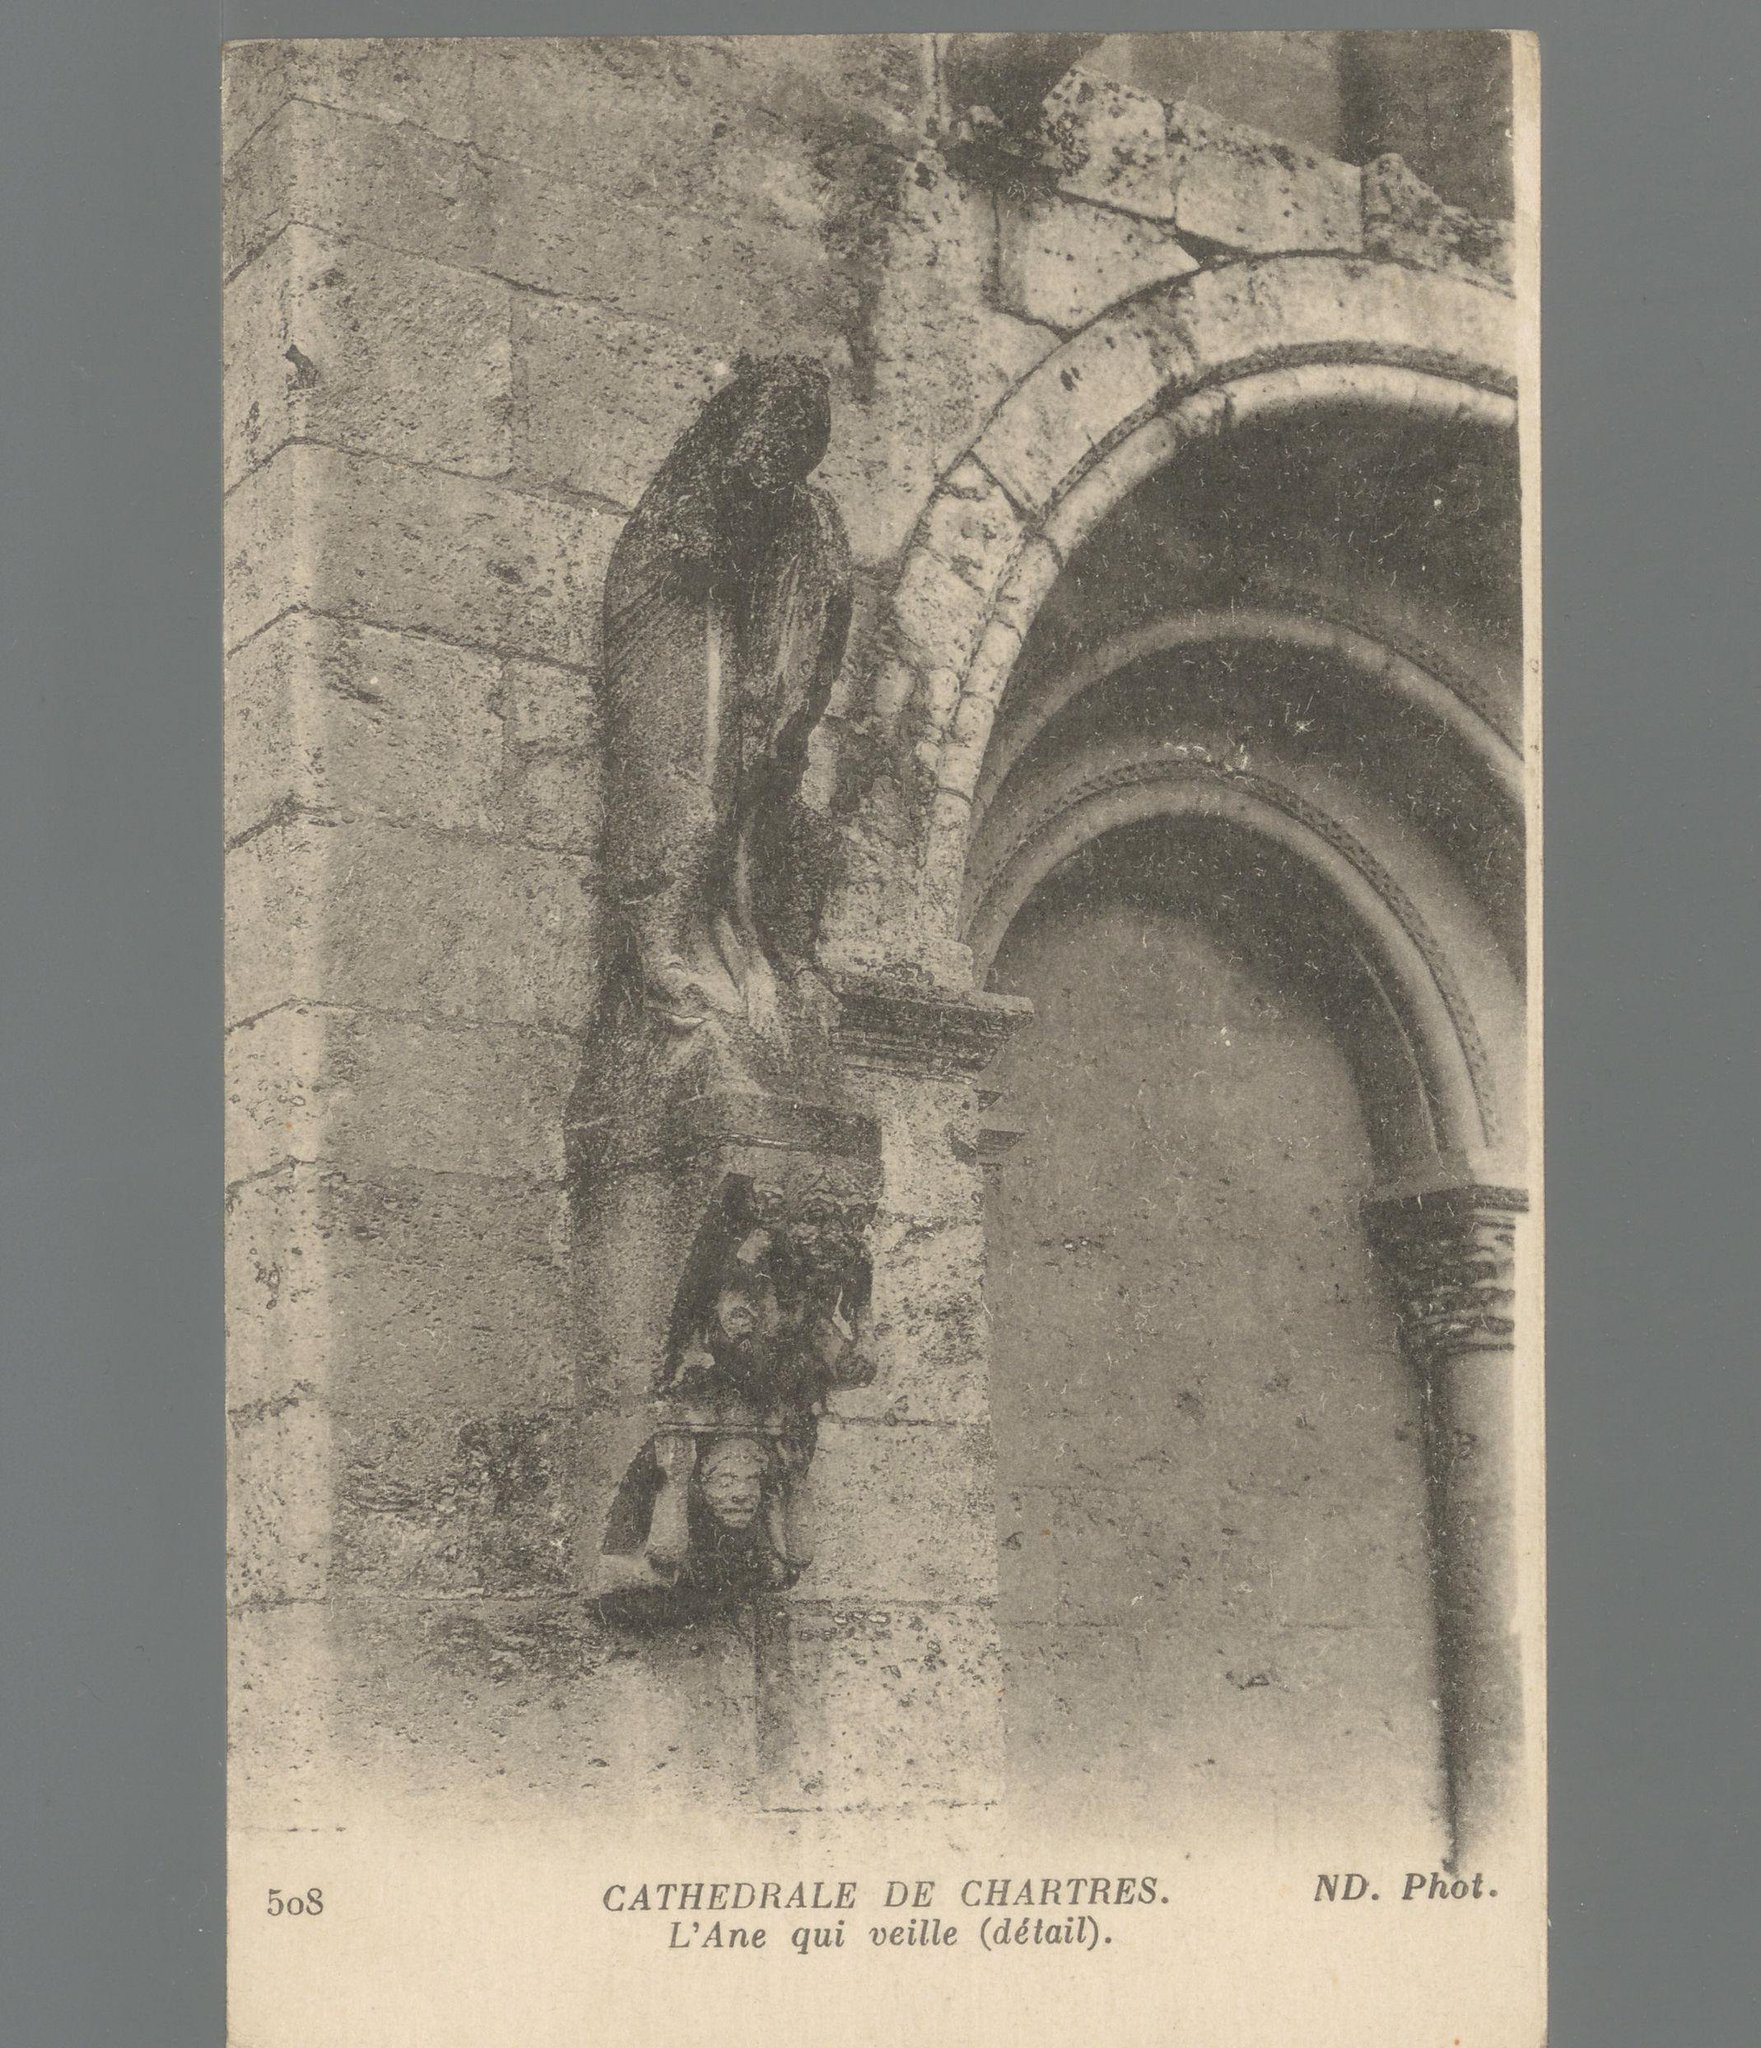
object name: photomechanical print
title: Cathedrale de Chartres. L'Ane qui veille (détail)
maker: Anonymous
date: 1918-1920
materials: cardboard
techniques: photograph, writing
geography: paris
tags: ass, donkey, church (exterior), statues, paintings, etc. ~ objects of worship in roman religion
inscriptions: postage stamp, collector's mark: ‘AFE v S’